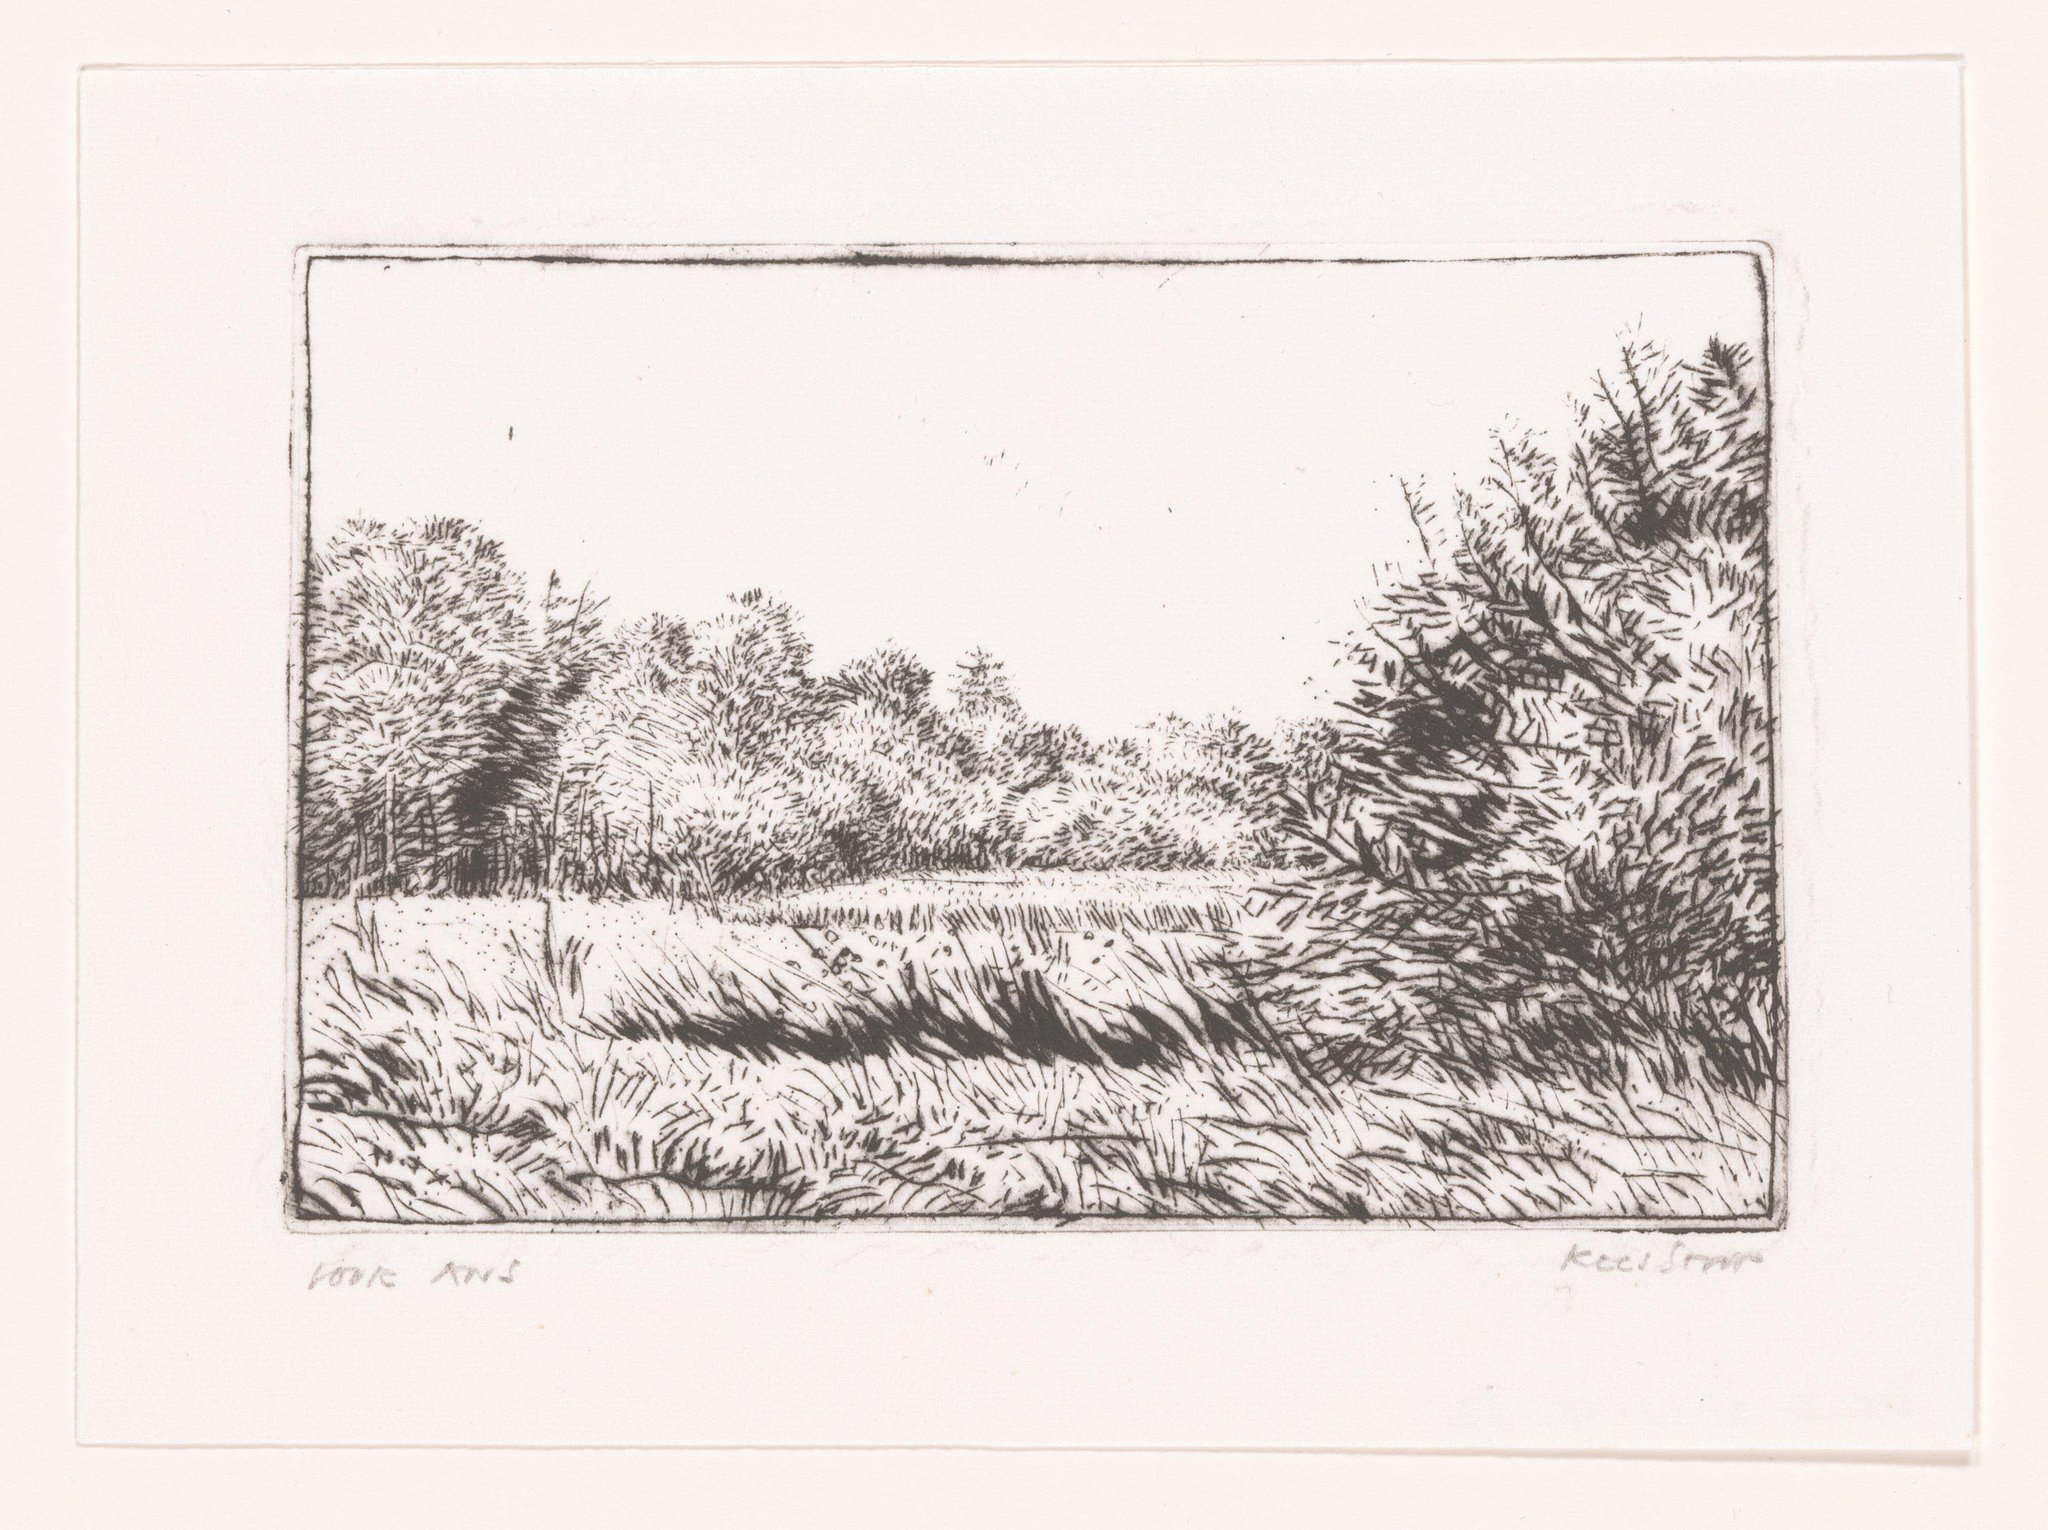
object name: print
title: Rietland met bomen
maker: kees stoop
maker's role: draughtsman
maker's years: 1929-2019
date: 1944-1990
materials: paper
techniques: etching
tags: trees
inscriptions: inscription: ‘VOOR KOOS’, signature: ‘KEES STOOP’